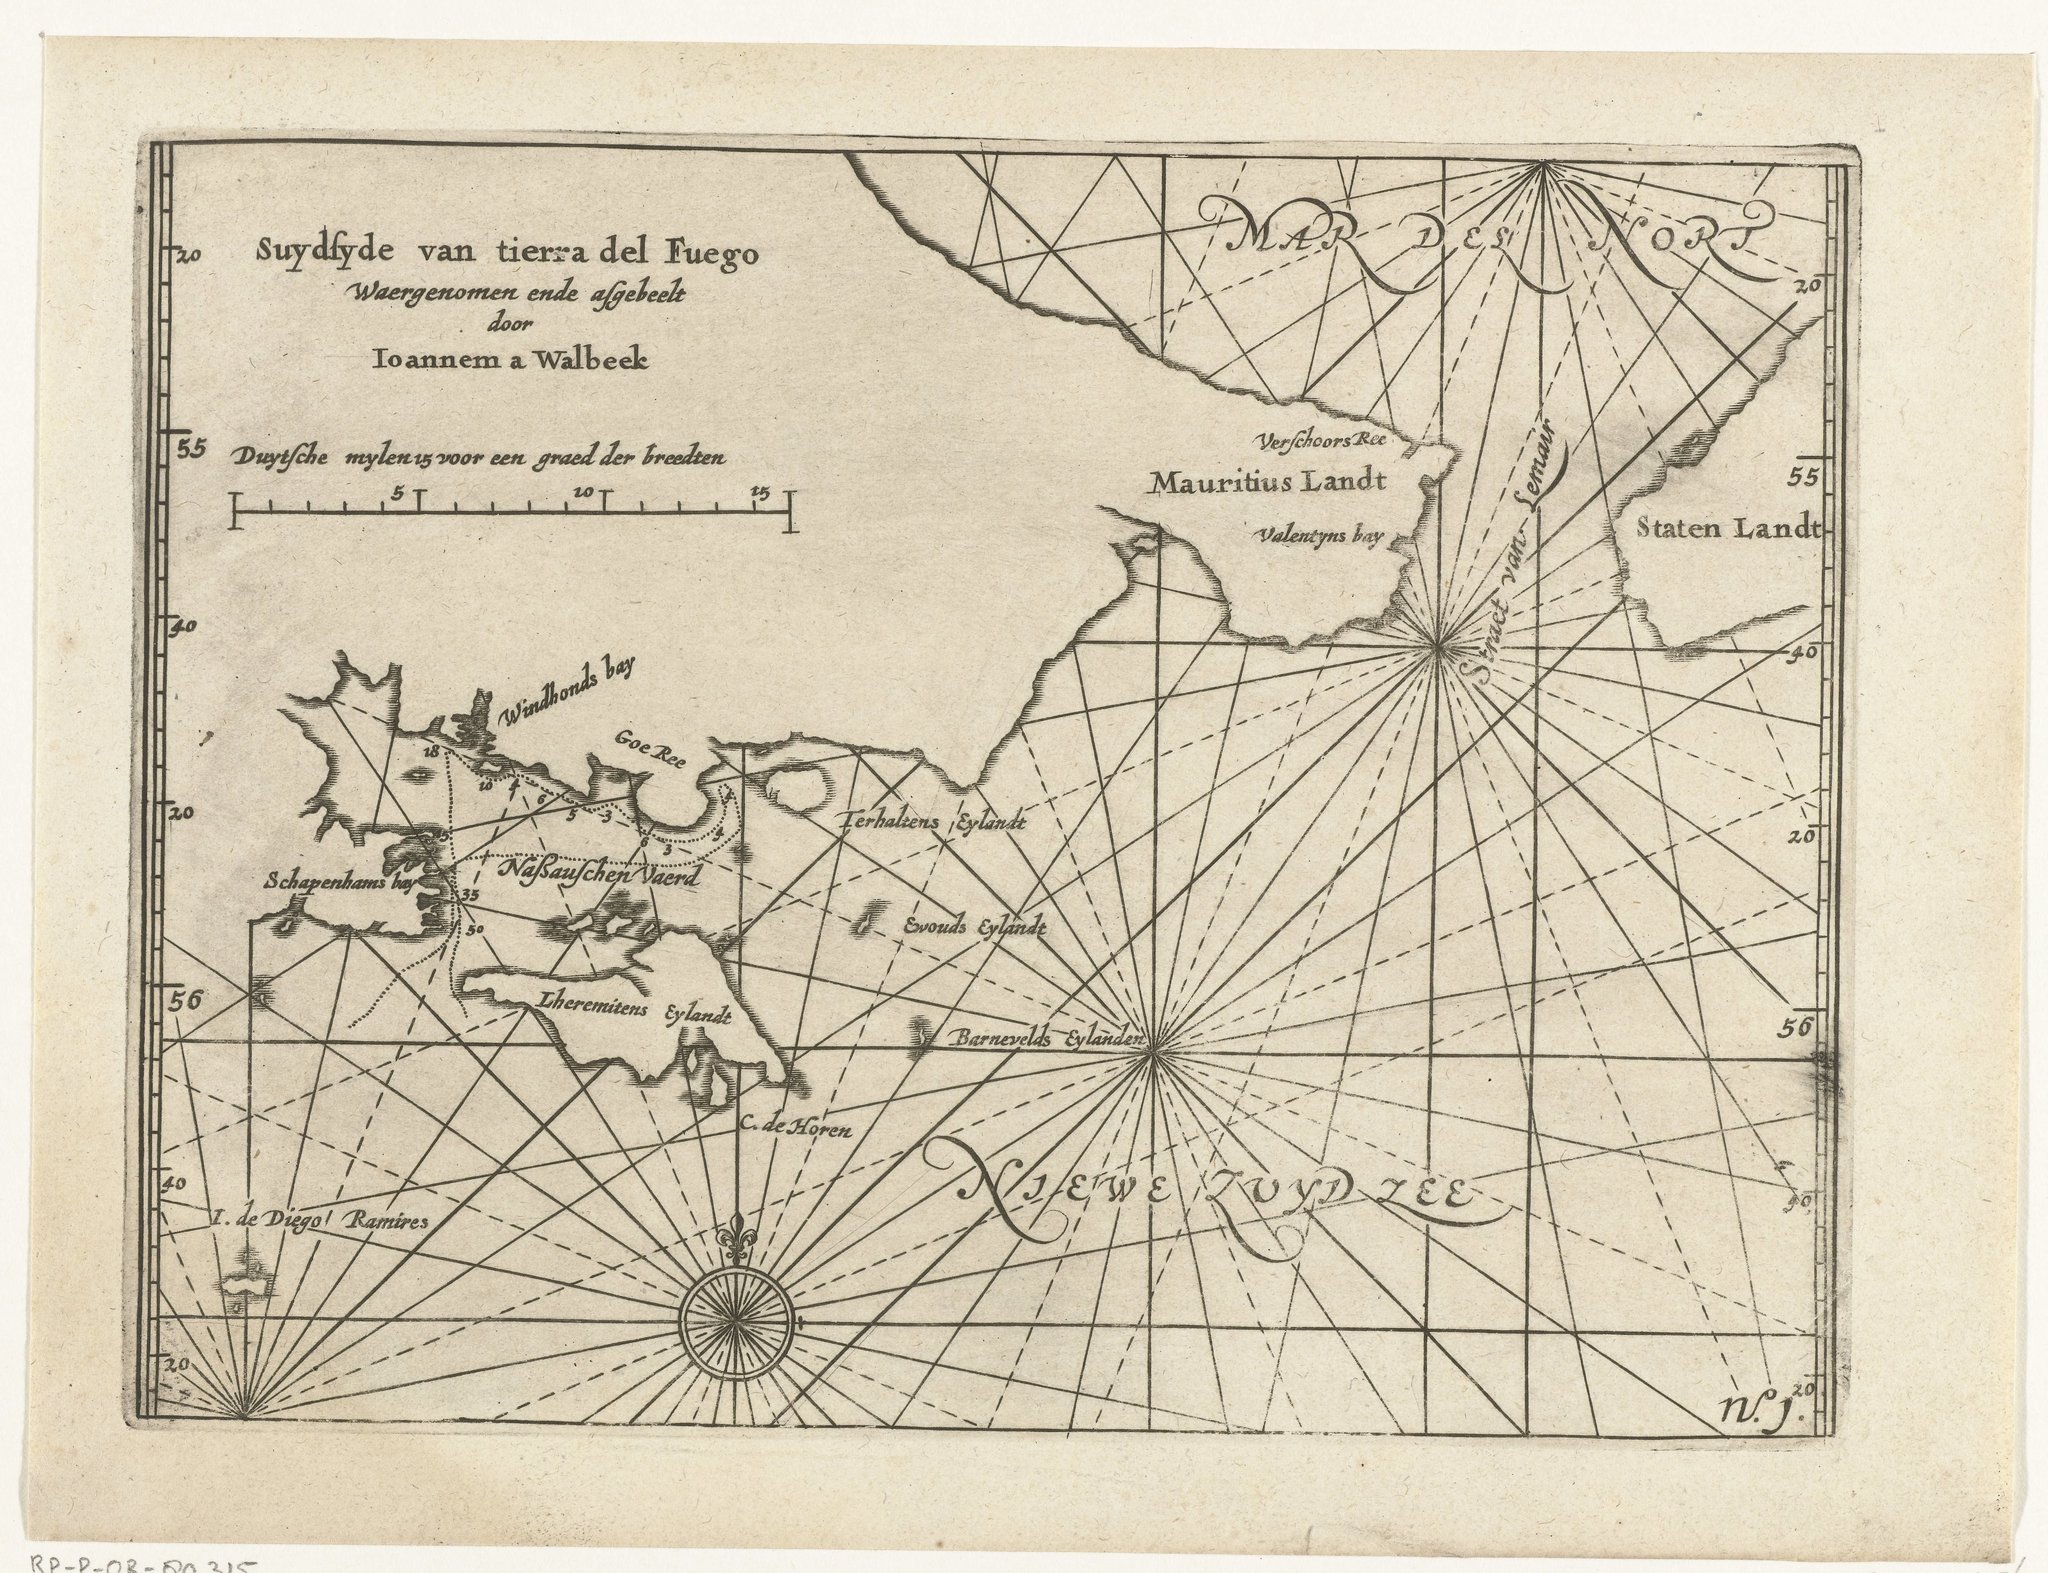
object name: map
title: Suydsyde van tierra del Fuego Waergenomen ende afgebeelt door Ioannem a Walbeek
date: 1644-1646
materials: paper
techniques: engraving, etching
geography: northern netherlands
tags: jacques l' heremite (ii), maps of separate countries or regions, landscapes in polar regions, exploration, expedition, voyage of discovery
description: Oorspronkelijke illustraties eerst gebruikt in: Johan van Walbeeck, Iovrnael vande Nassausche vloot, ofte Beschryvingh vande voyagie om den gantschen aerdt-cloot (...) onder't beleydt vanden admirael Iaques l'Heremite, H. Gerritsz en J.P. Wachter, Amsterdam 1626. Kopieën naar deze platen gebruikt in: Journael van de Nassausche Vloot, ofte Beschrijvingh van de Voyagie om den gantschen Aerd-Kloot, Gedaen met elf Schepen: Onder 't Beleydt van den Admirael Jaques l'Heremite, Ende Vice-Admirael Gheen Huygen Schapenham, In de Jaren 1623. 1624. 1625. en 1626. Opgenomen in: I. Commelin, Begin ende voortgangh, van de Vereenighde Nederlantsche Geoctroyeerde Oost-Indische Compagnie, J. Janssonius, Amsterdam 1646. Genummerd: No. 1.